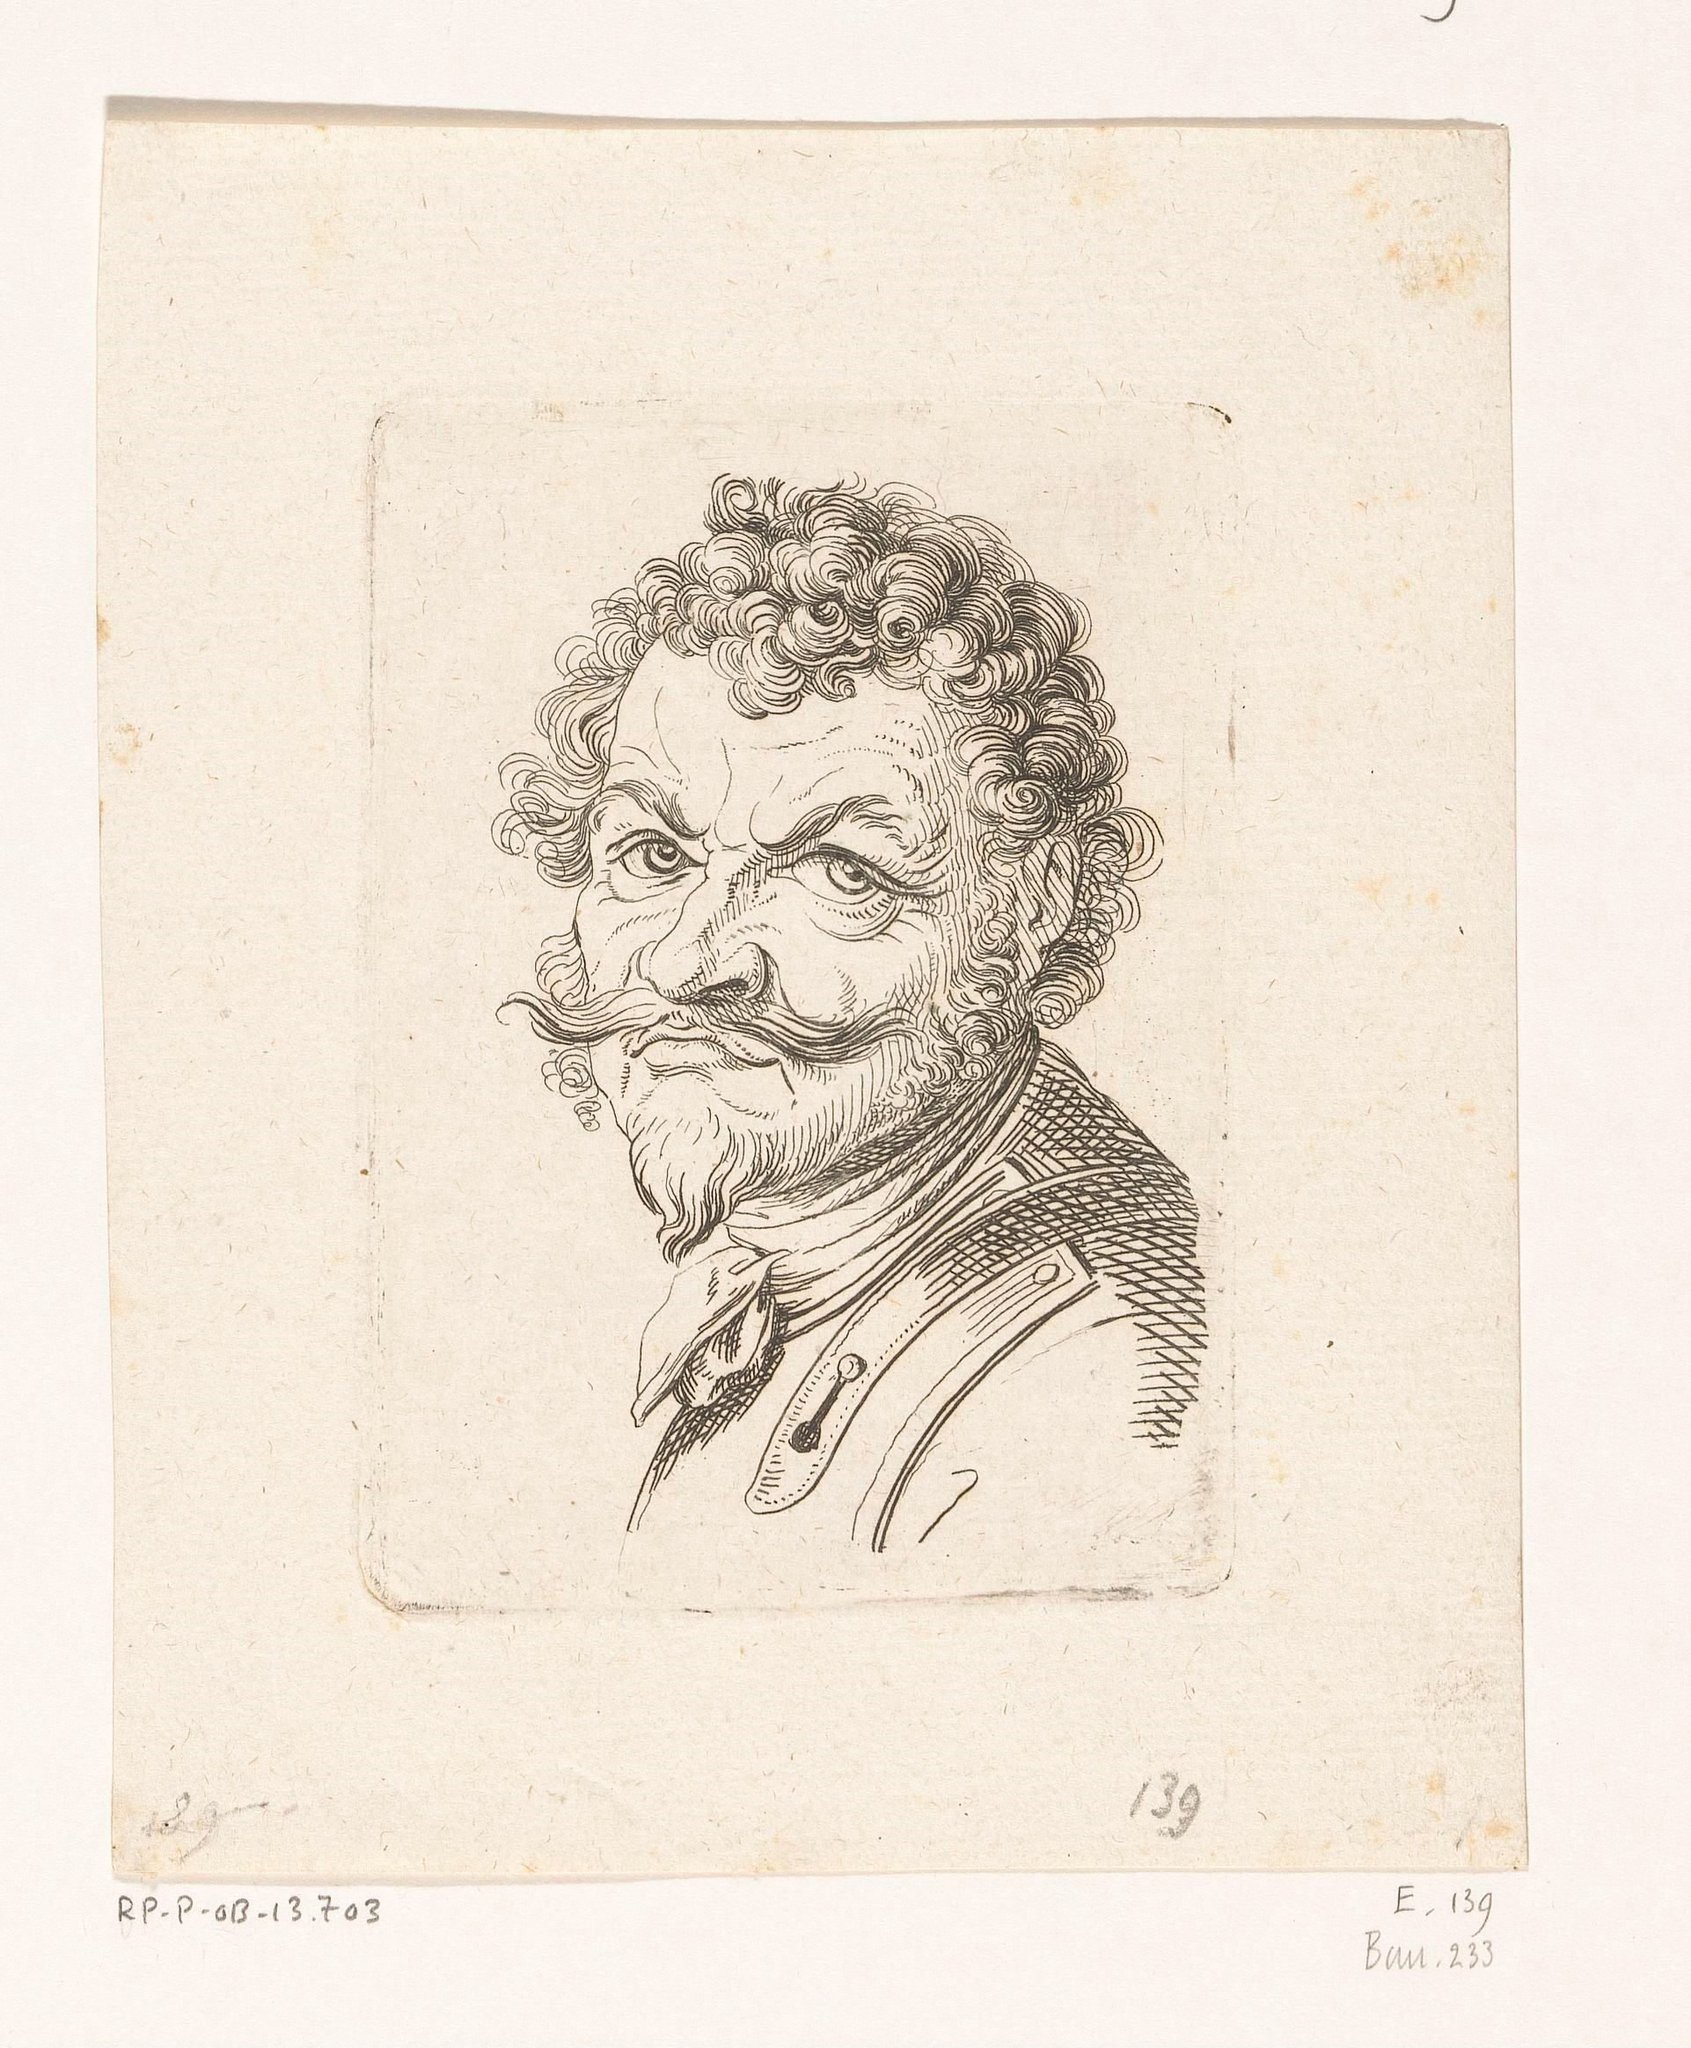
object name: print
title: Wreedheid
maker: daniel nikolaus chodowiecki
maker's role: draughtsman, print maker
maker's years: 1726-1801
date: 1775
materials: paper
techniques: etching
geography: berlin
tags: johann caspar lavater, parts of the face, armour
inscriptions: collector's mark: Lugt 2228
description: Prent ook gebruikt in: Lavater, Johann Kaspar. Physiognomische Fragmente zur Beförderung der Menschenkenntniß und Menschenliebe. Winterthur: Heinrich Steiners en Compagnie, 1787, dl. 3. Chodowiecki maakte deze prent op basis van een tekening door Johann Kaspar Lavater.